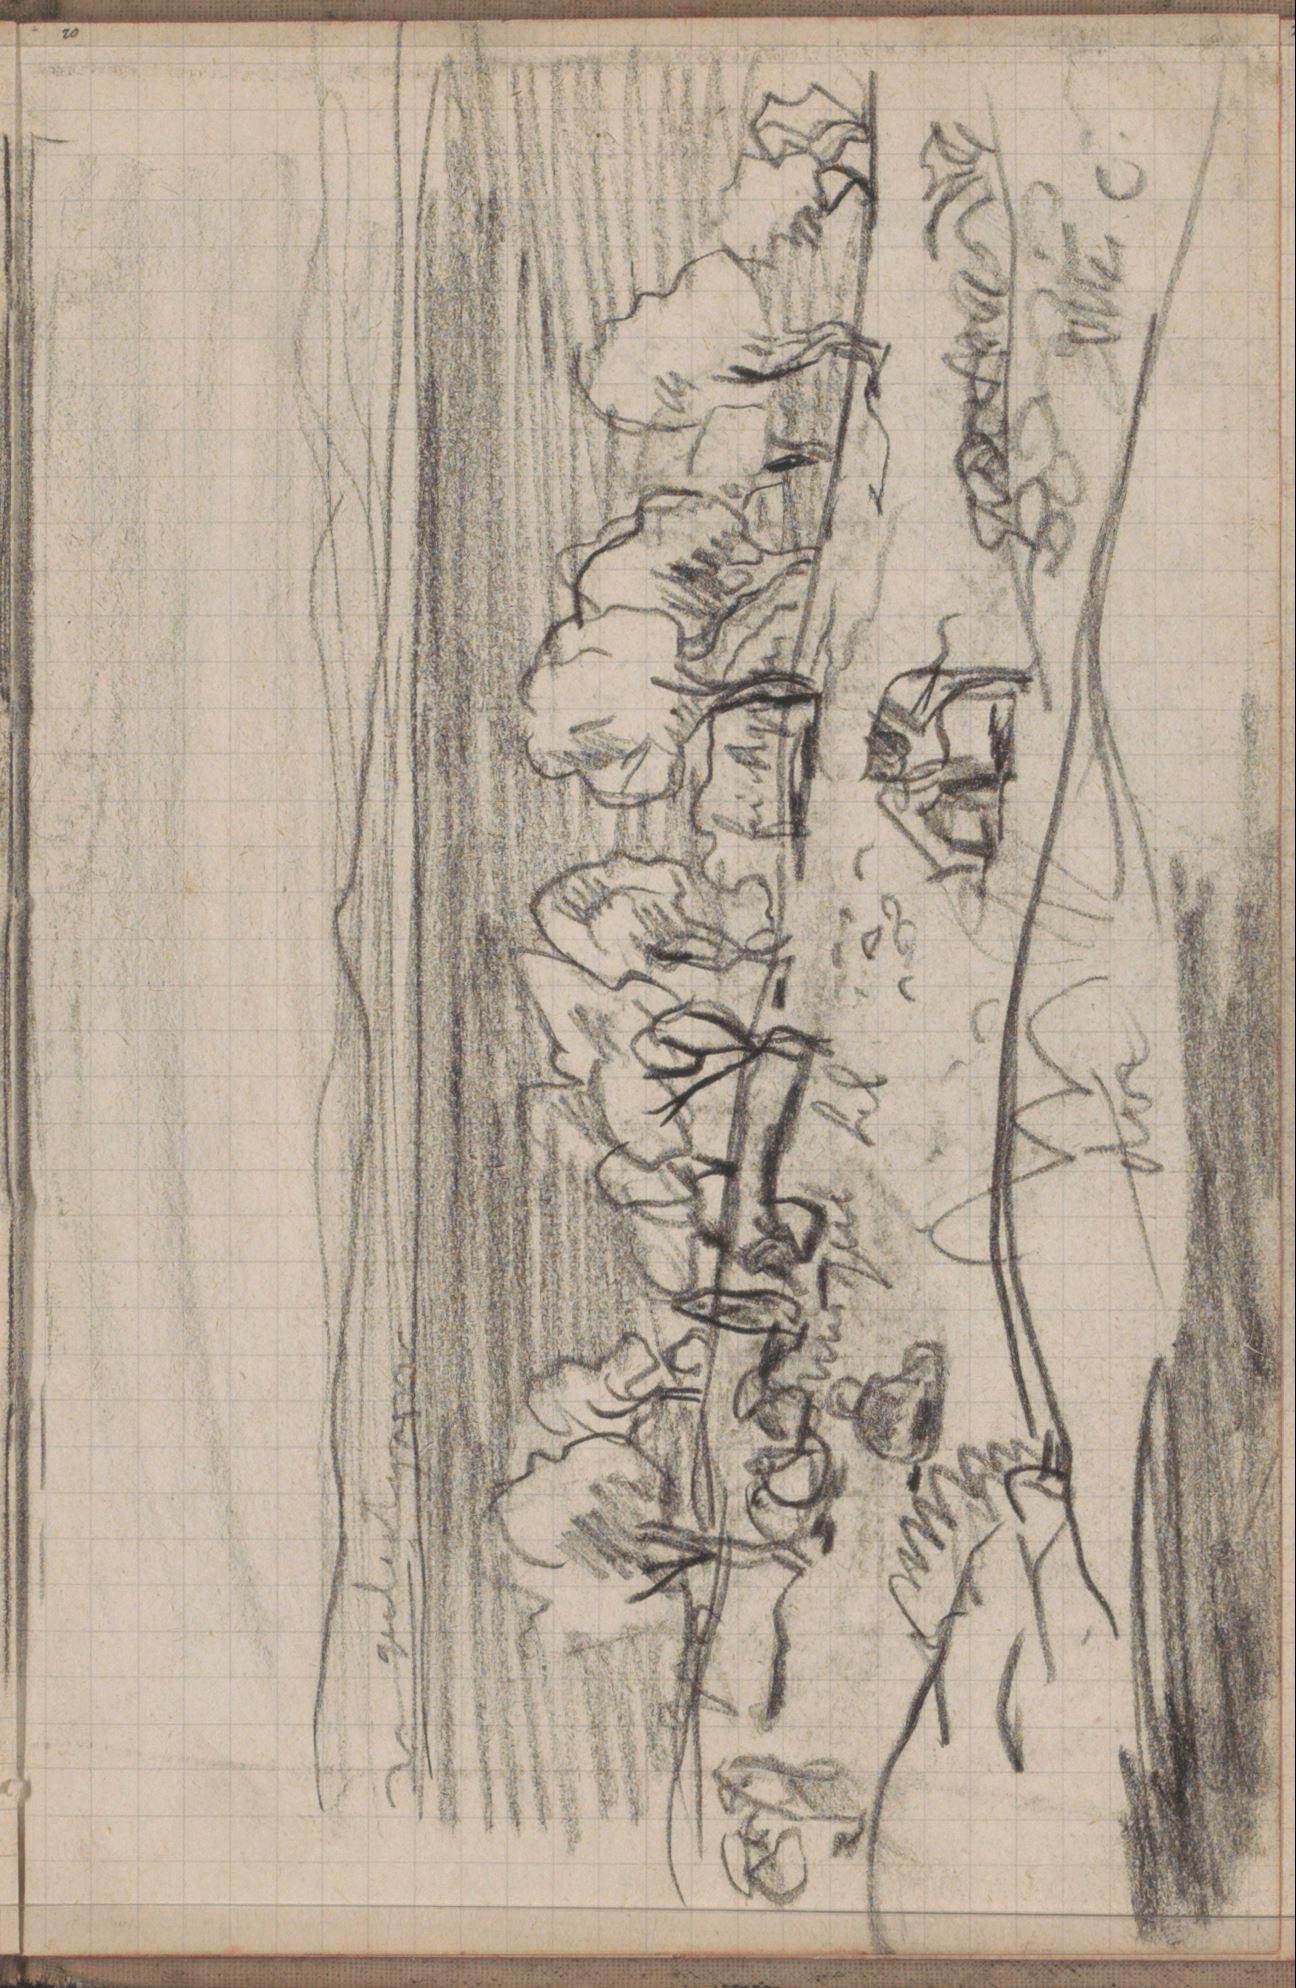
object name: sketchbook leaf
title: Heuvelachtig landschap met water en bomen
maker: marius bauer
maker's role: draughtsman, print maker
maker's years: 1867-1932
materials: chalk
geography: istanbul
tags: trees, landscapes with waters, waterscapes, seascapes (in the temperate zone), horse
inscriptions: kleurnotitie, handgeschreven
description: Vermoedelijk een gezicht op de Bosporus. Op de voorgrond een zittende figuur en grazend paard. Pagina 20 uit een schetsboek met 54 bladen.